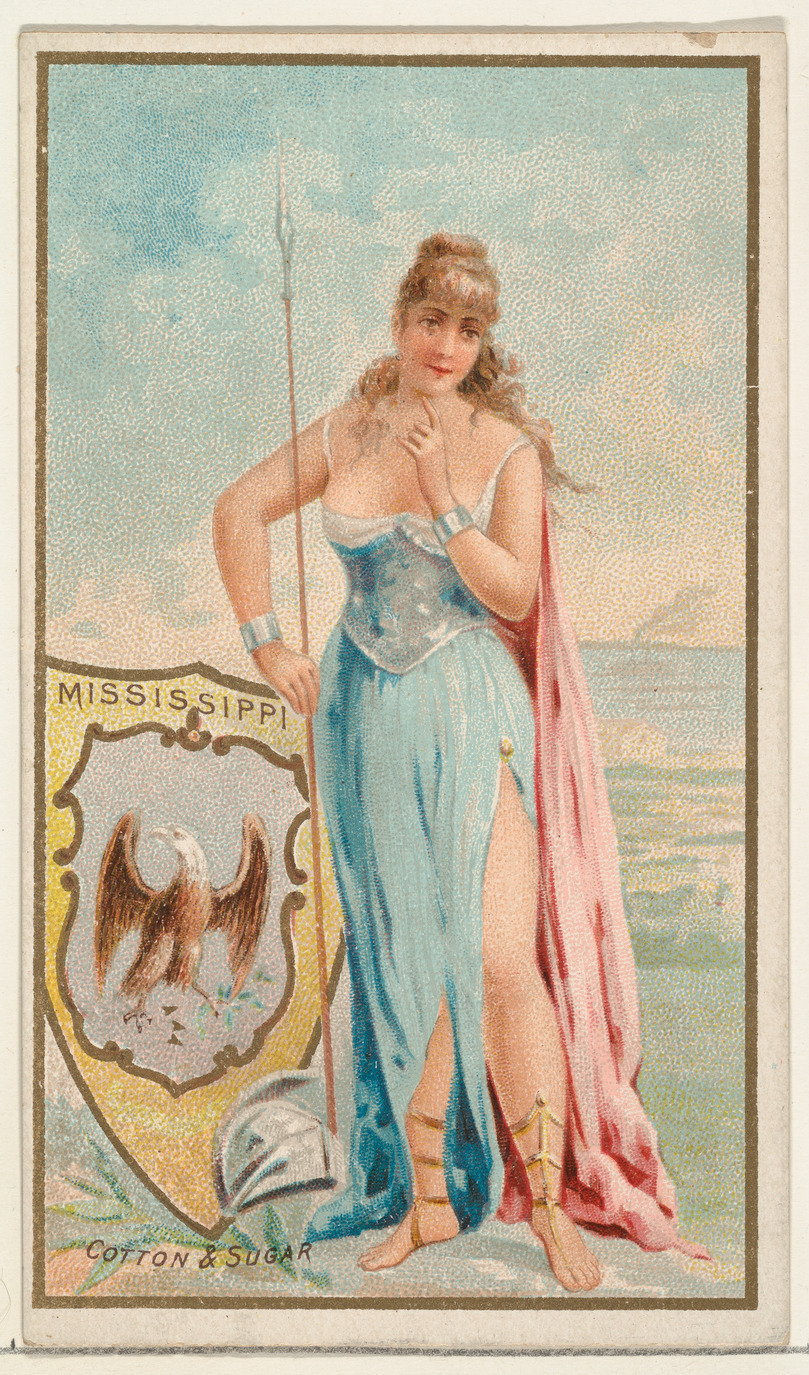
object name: print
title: Mississippi, from the Industries of States series (N117) issued by Duke Sons & Co. to promote Honest Long Cut Tobacco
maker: w. duke, sons & co.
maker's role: publisher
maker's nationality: american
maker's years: 1870-1920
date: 1889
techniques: color lithograph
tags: shields,women